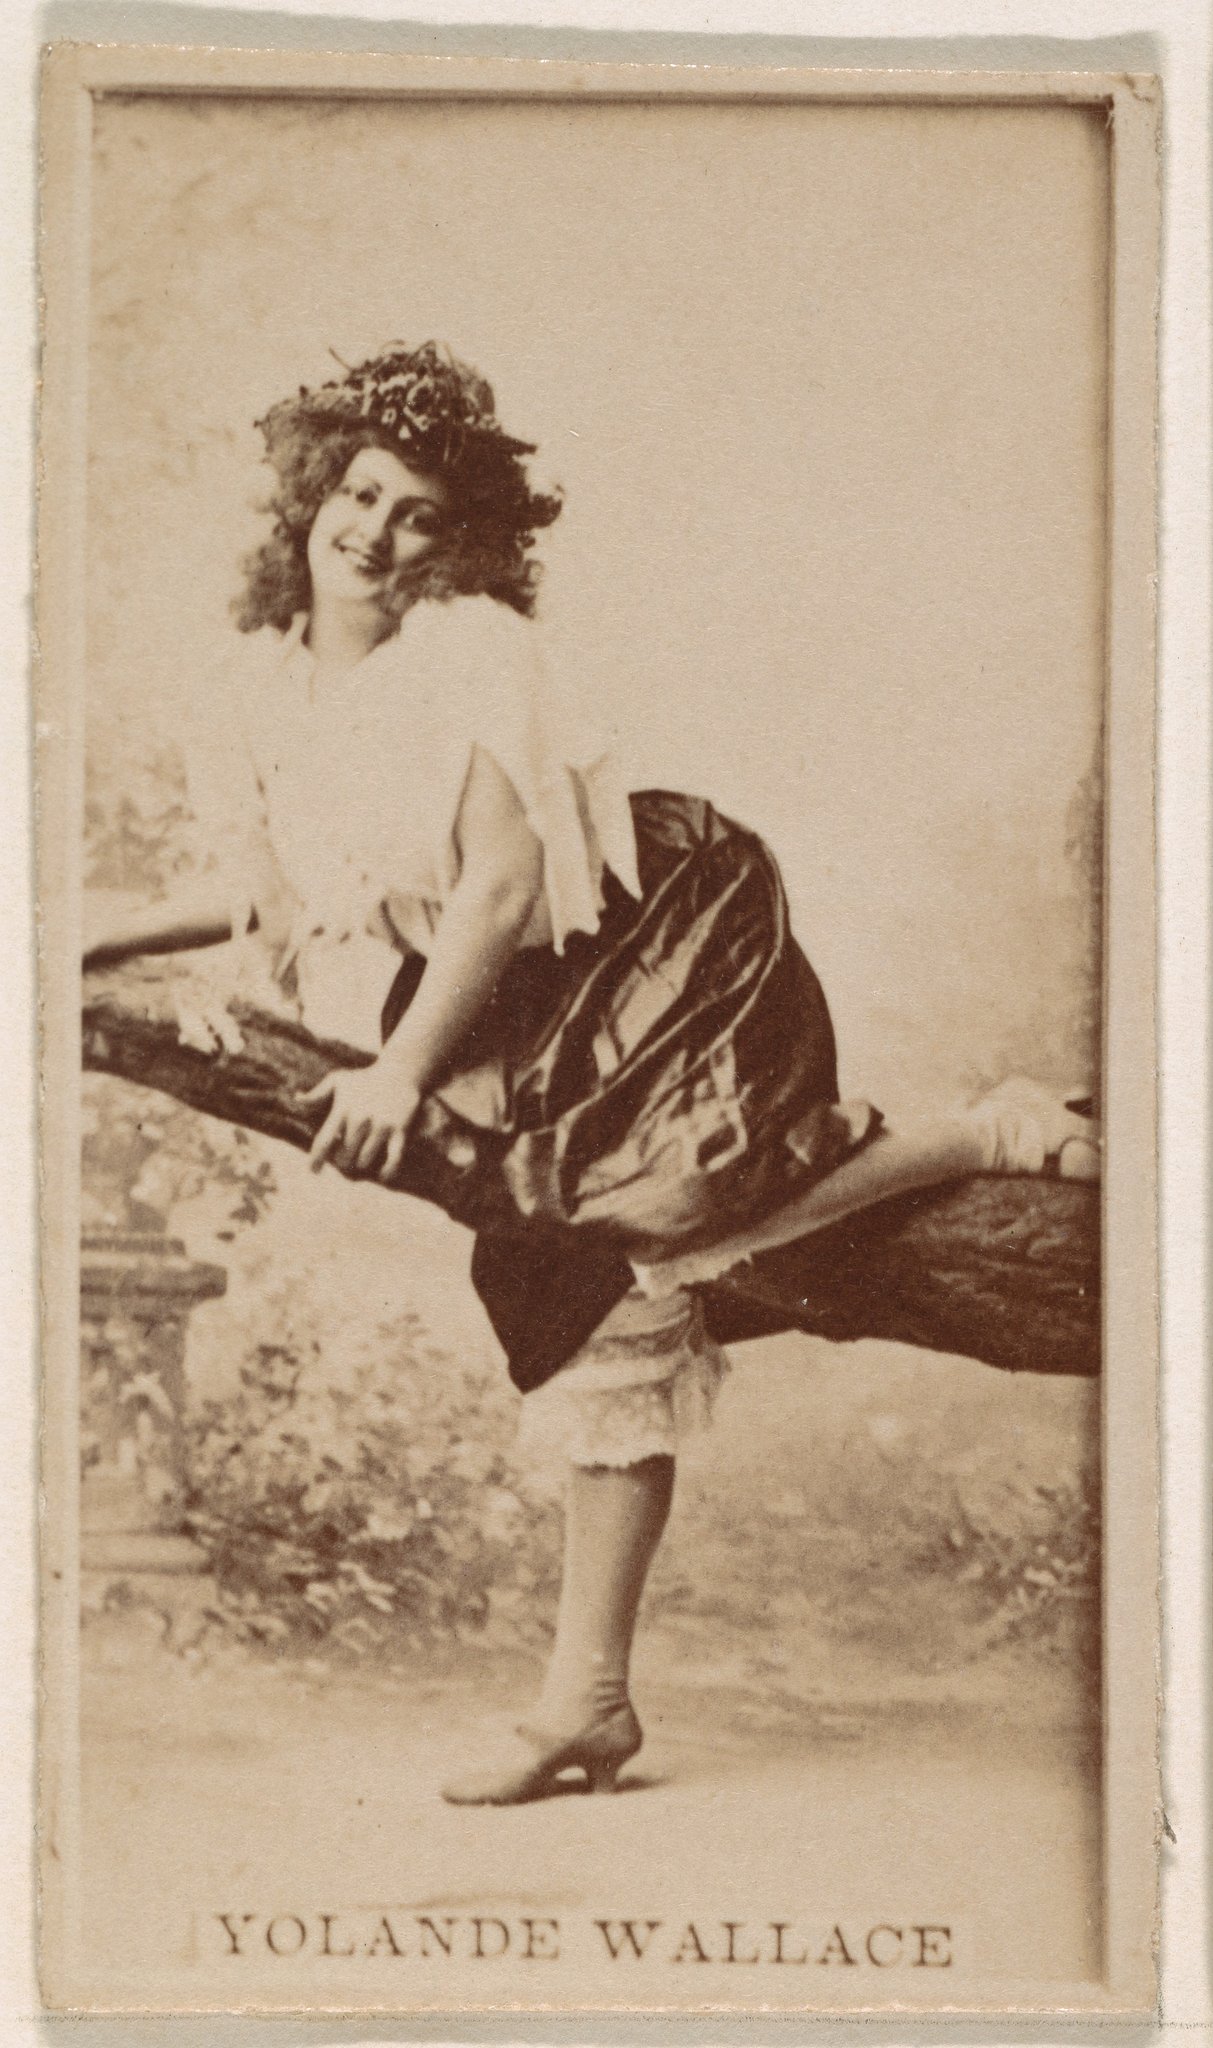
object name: photograph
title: Yolande Wallace, from the Actresses series (N245) issued by Kinney Brothers to promote Sweet Caporal Cigarettes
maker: kinney brothers tobacco company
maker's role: publisher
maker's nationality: american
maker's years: 1869-2011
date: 1890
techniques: albumen silver print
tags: portraits,women,actresses